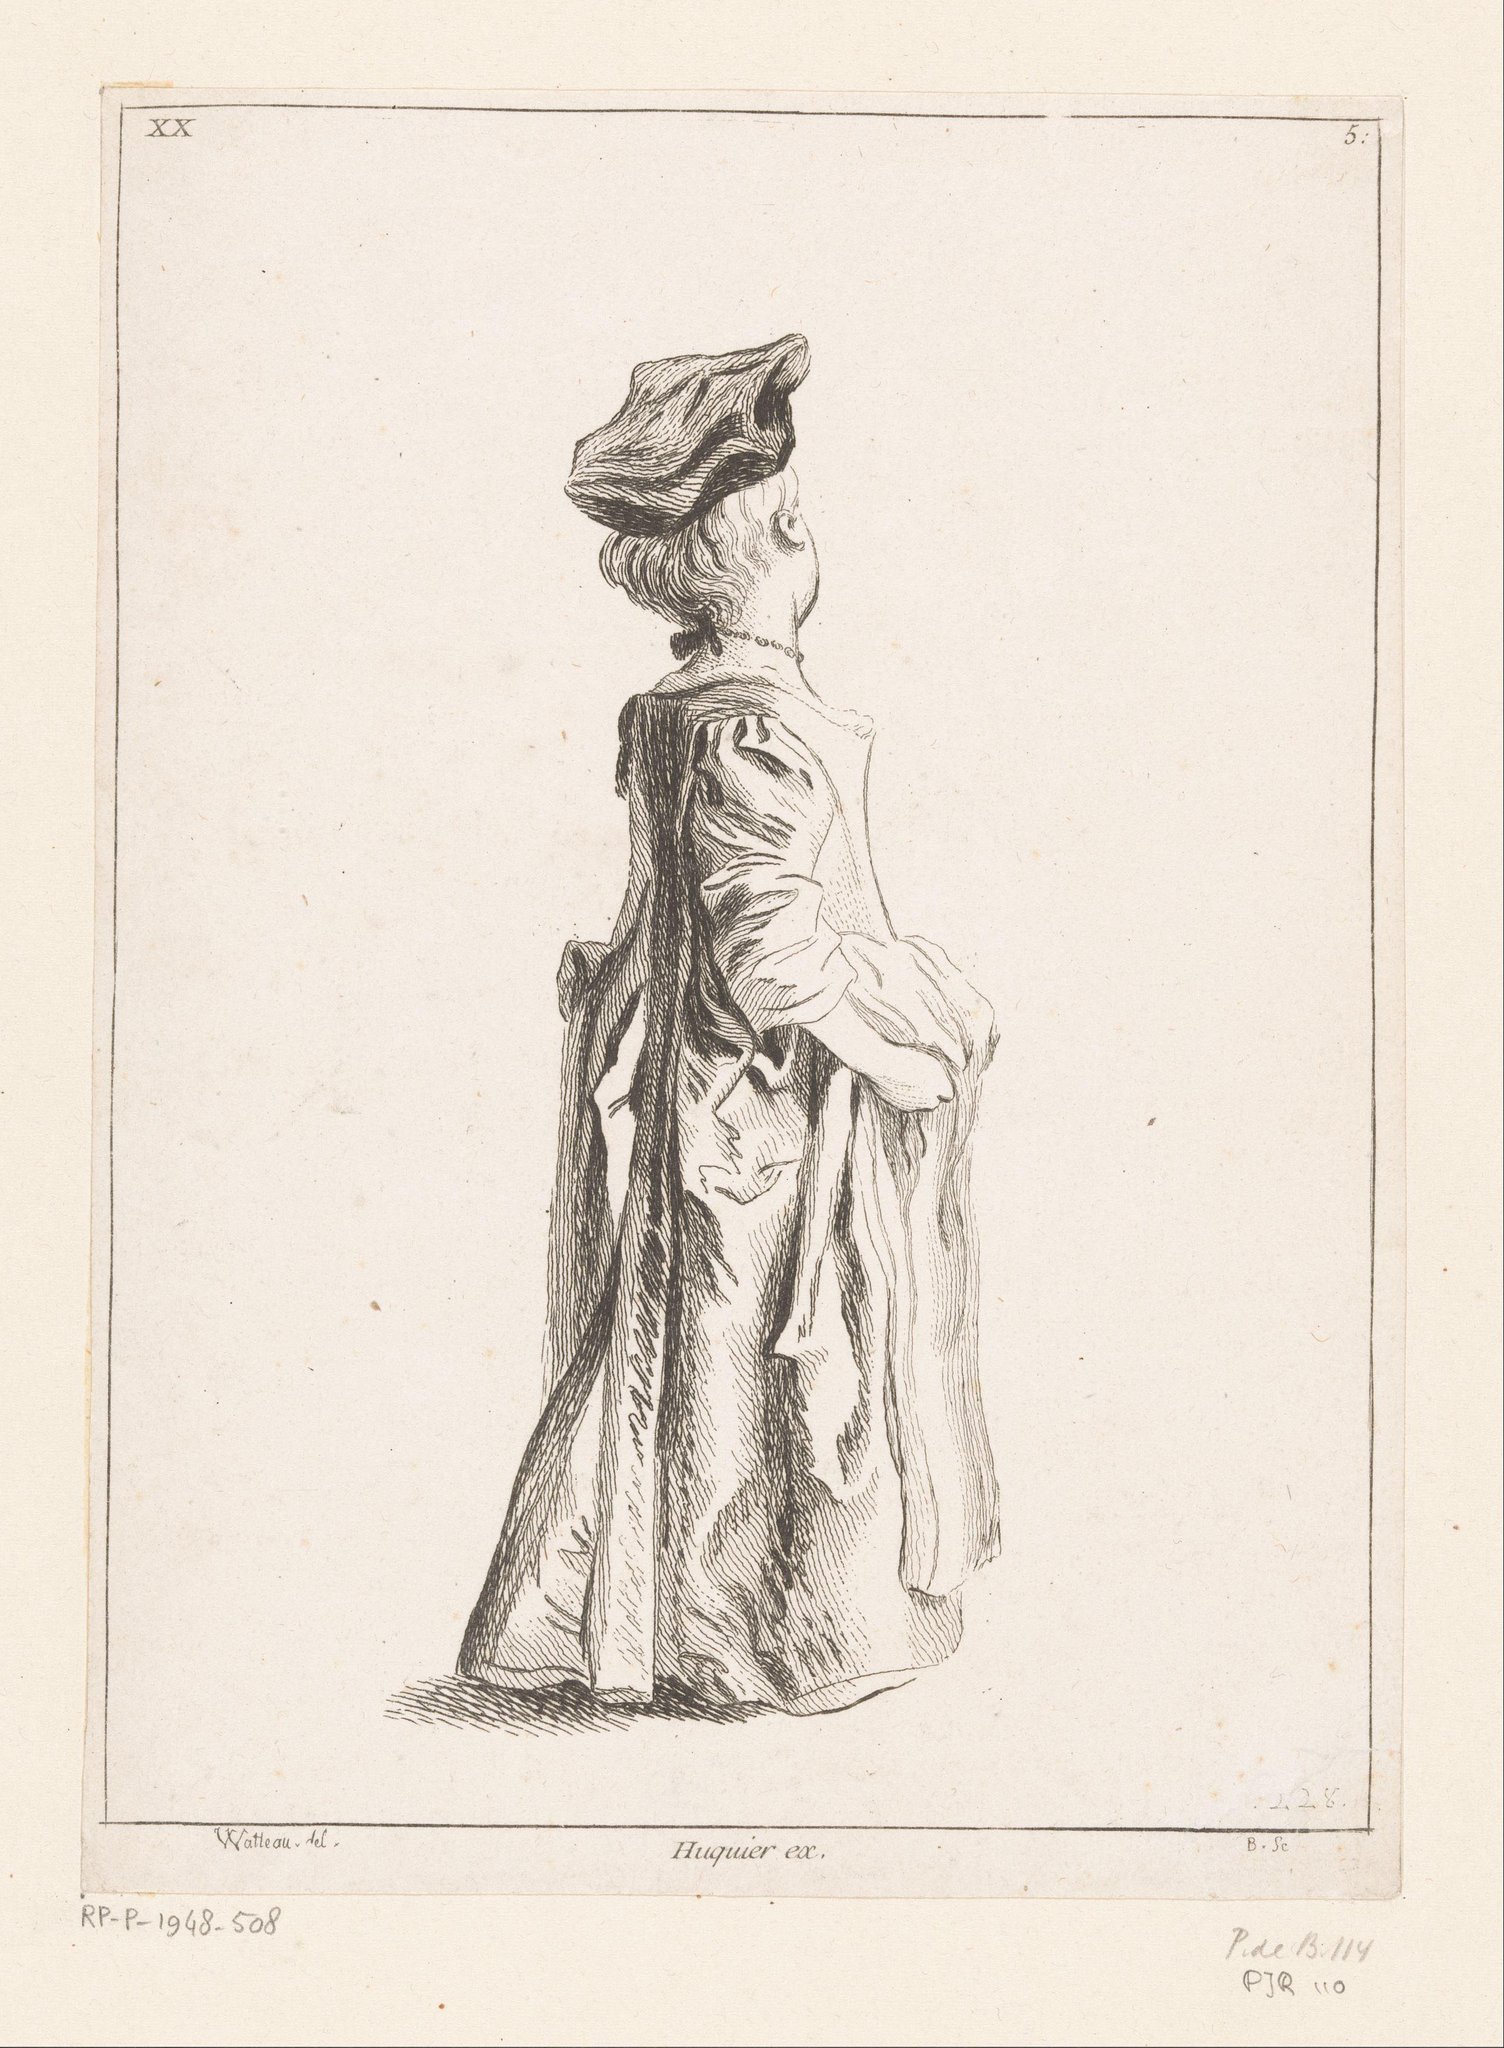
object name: print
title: Staand meisje op de rug gezien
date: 1728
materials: paper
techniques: etching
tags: head-gear, girl (child between toddler and youth)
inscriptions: collector's mark: Lugt 2228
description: Maakt deel uit van een serie van 351 prenten, naar tekeningen door Watteau, getiteld 'Figures de différents caractères, de Paysages, et d'Etudes dessinées d'après nature par Antoine Watteau peintre du Roy en son Académie Royale de Peinture et Sculpture Gravées à l'Eau forte par les plus habiles Peintres et Graveurs du temps, tirées des plus beaux cabinets de Paris'. De serie werd geëtst door vijftien verschillende kunstenaars en bestaat uit twee delen. Het eerste deel werd uitgegeven in 1726 en de tweede in 1728.